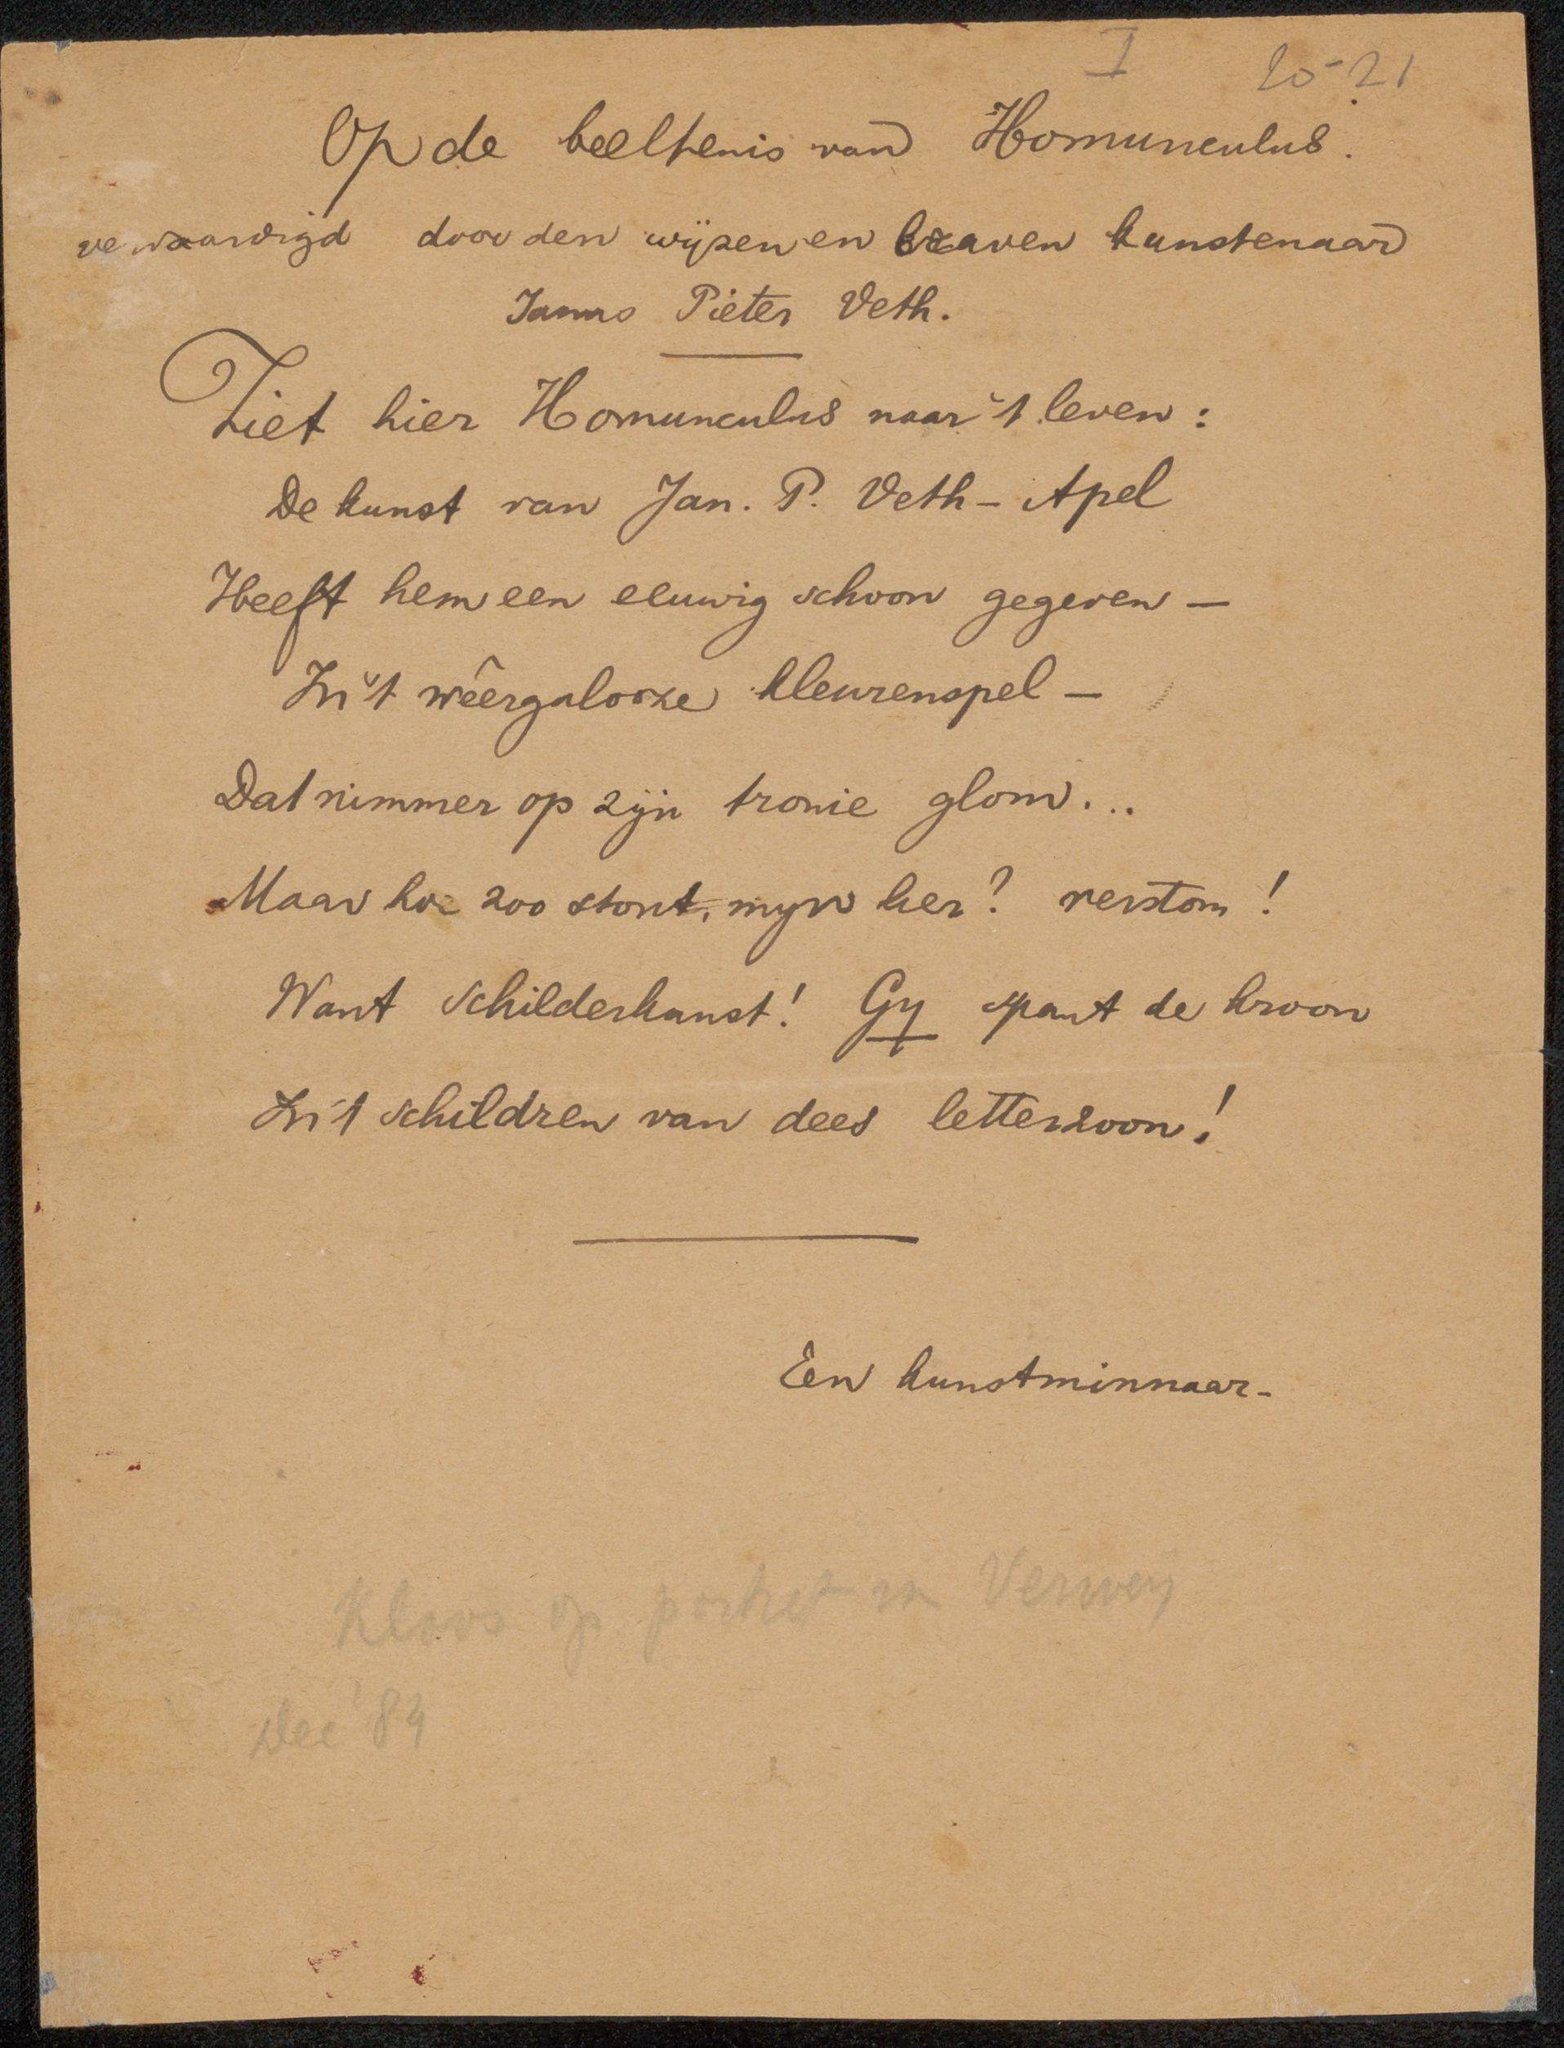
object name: poem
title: Op de beeltenis van Homunculus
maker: willem kloos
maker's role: dichter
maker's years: 1859-1938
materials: ink, paper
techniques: pen, writing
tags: painter, print maker, draughtsman, jan veth, albert verwey, literature ~ arts, historical persons (portraits and scenes from the life)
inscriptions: collector's mark: ‘RPK’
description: Homunculus is Alberts Verwey (1865-1937) pseudoniem.